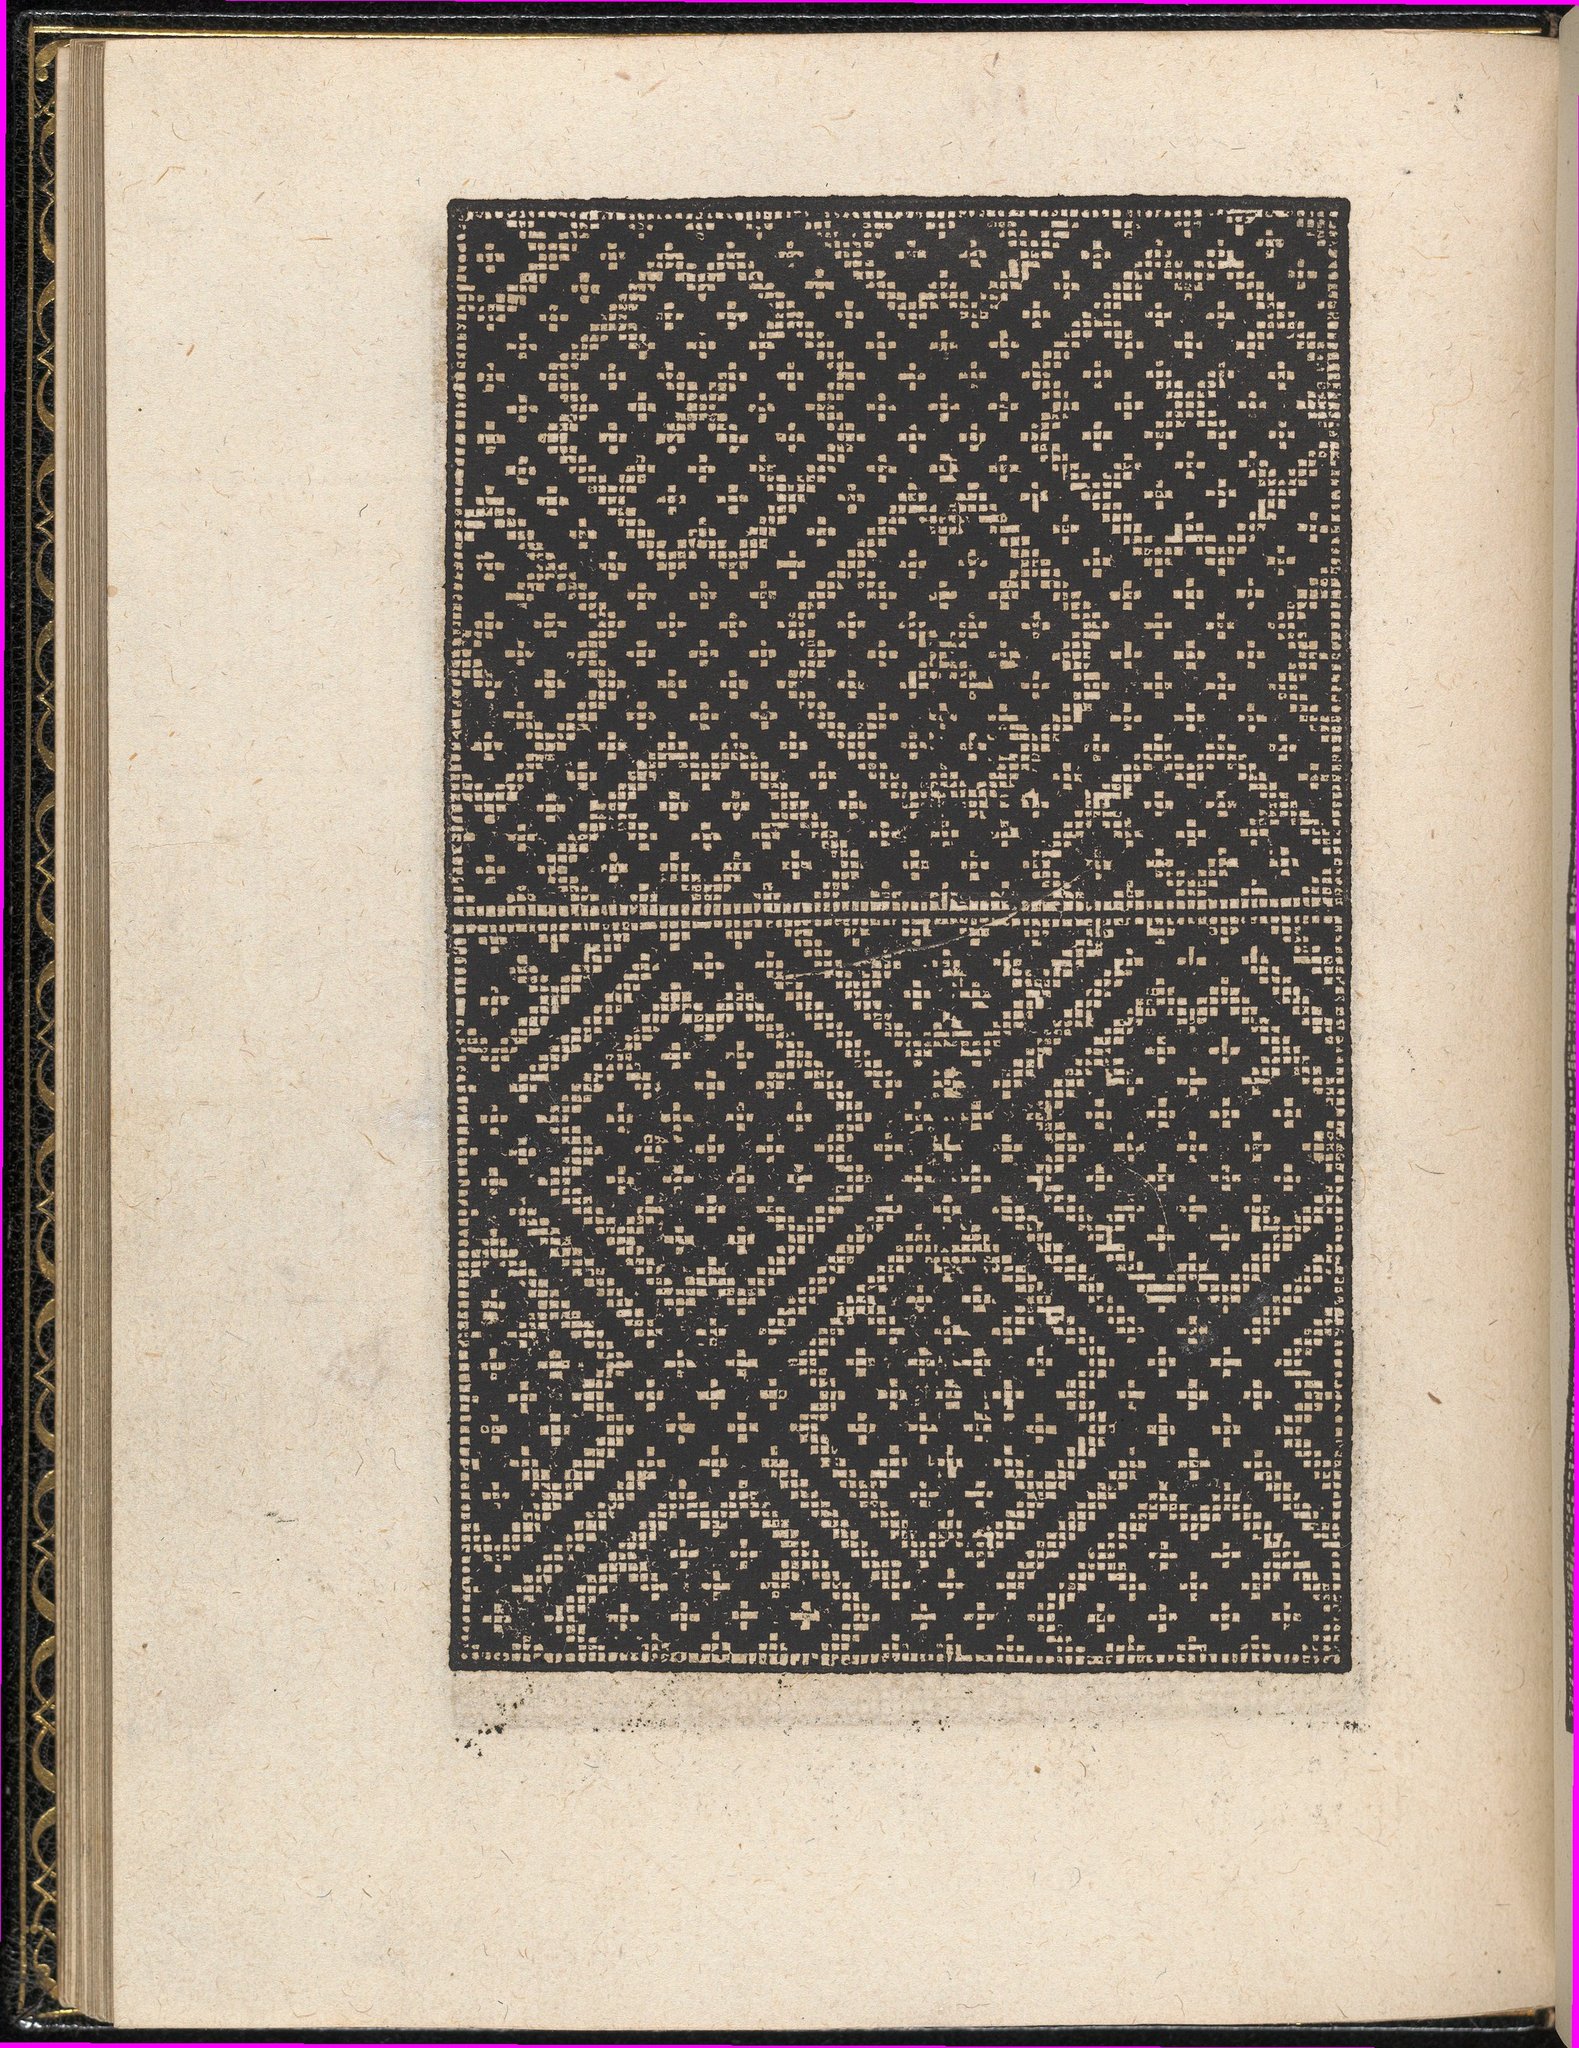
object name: book print ornament architecture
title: Page from Ein new kunstlich Modelbuch...(Page 26r)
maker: peter quentel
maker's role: publisher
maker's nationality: german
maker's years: 1500-1550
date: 1544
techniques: woodcut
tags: ornament